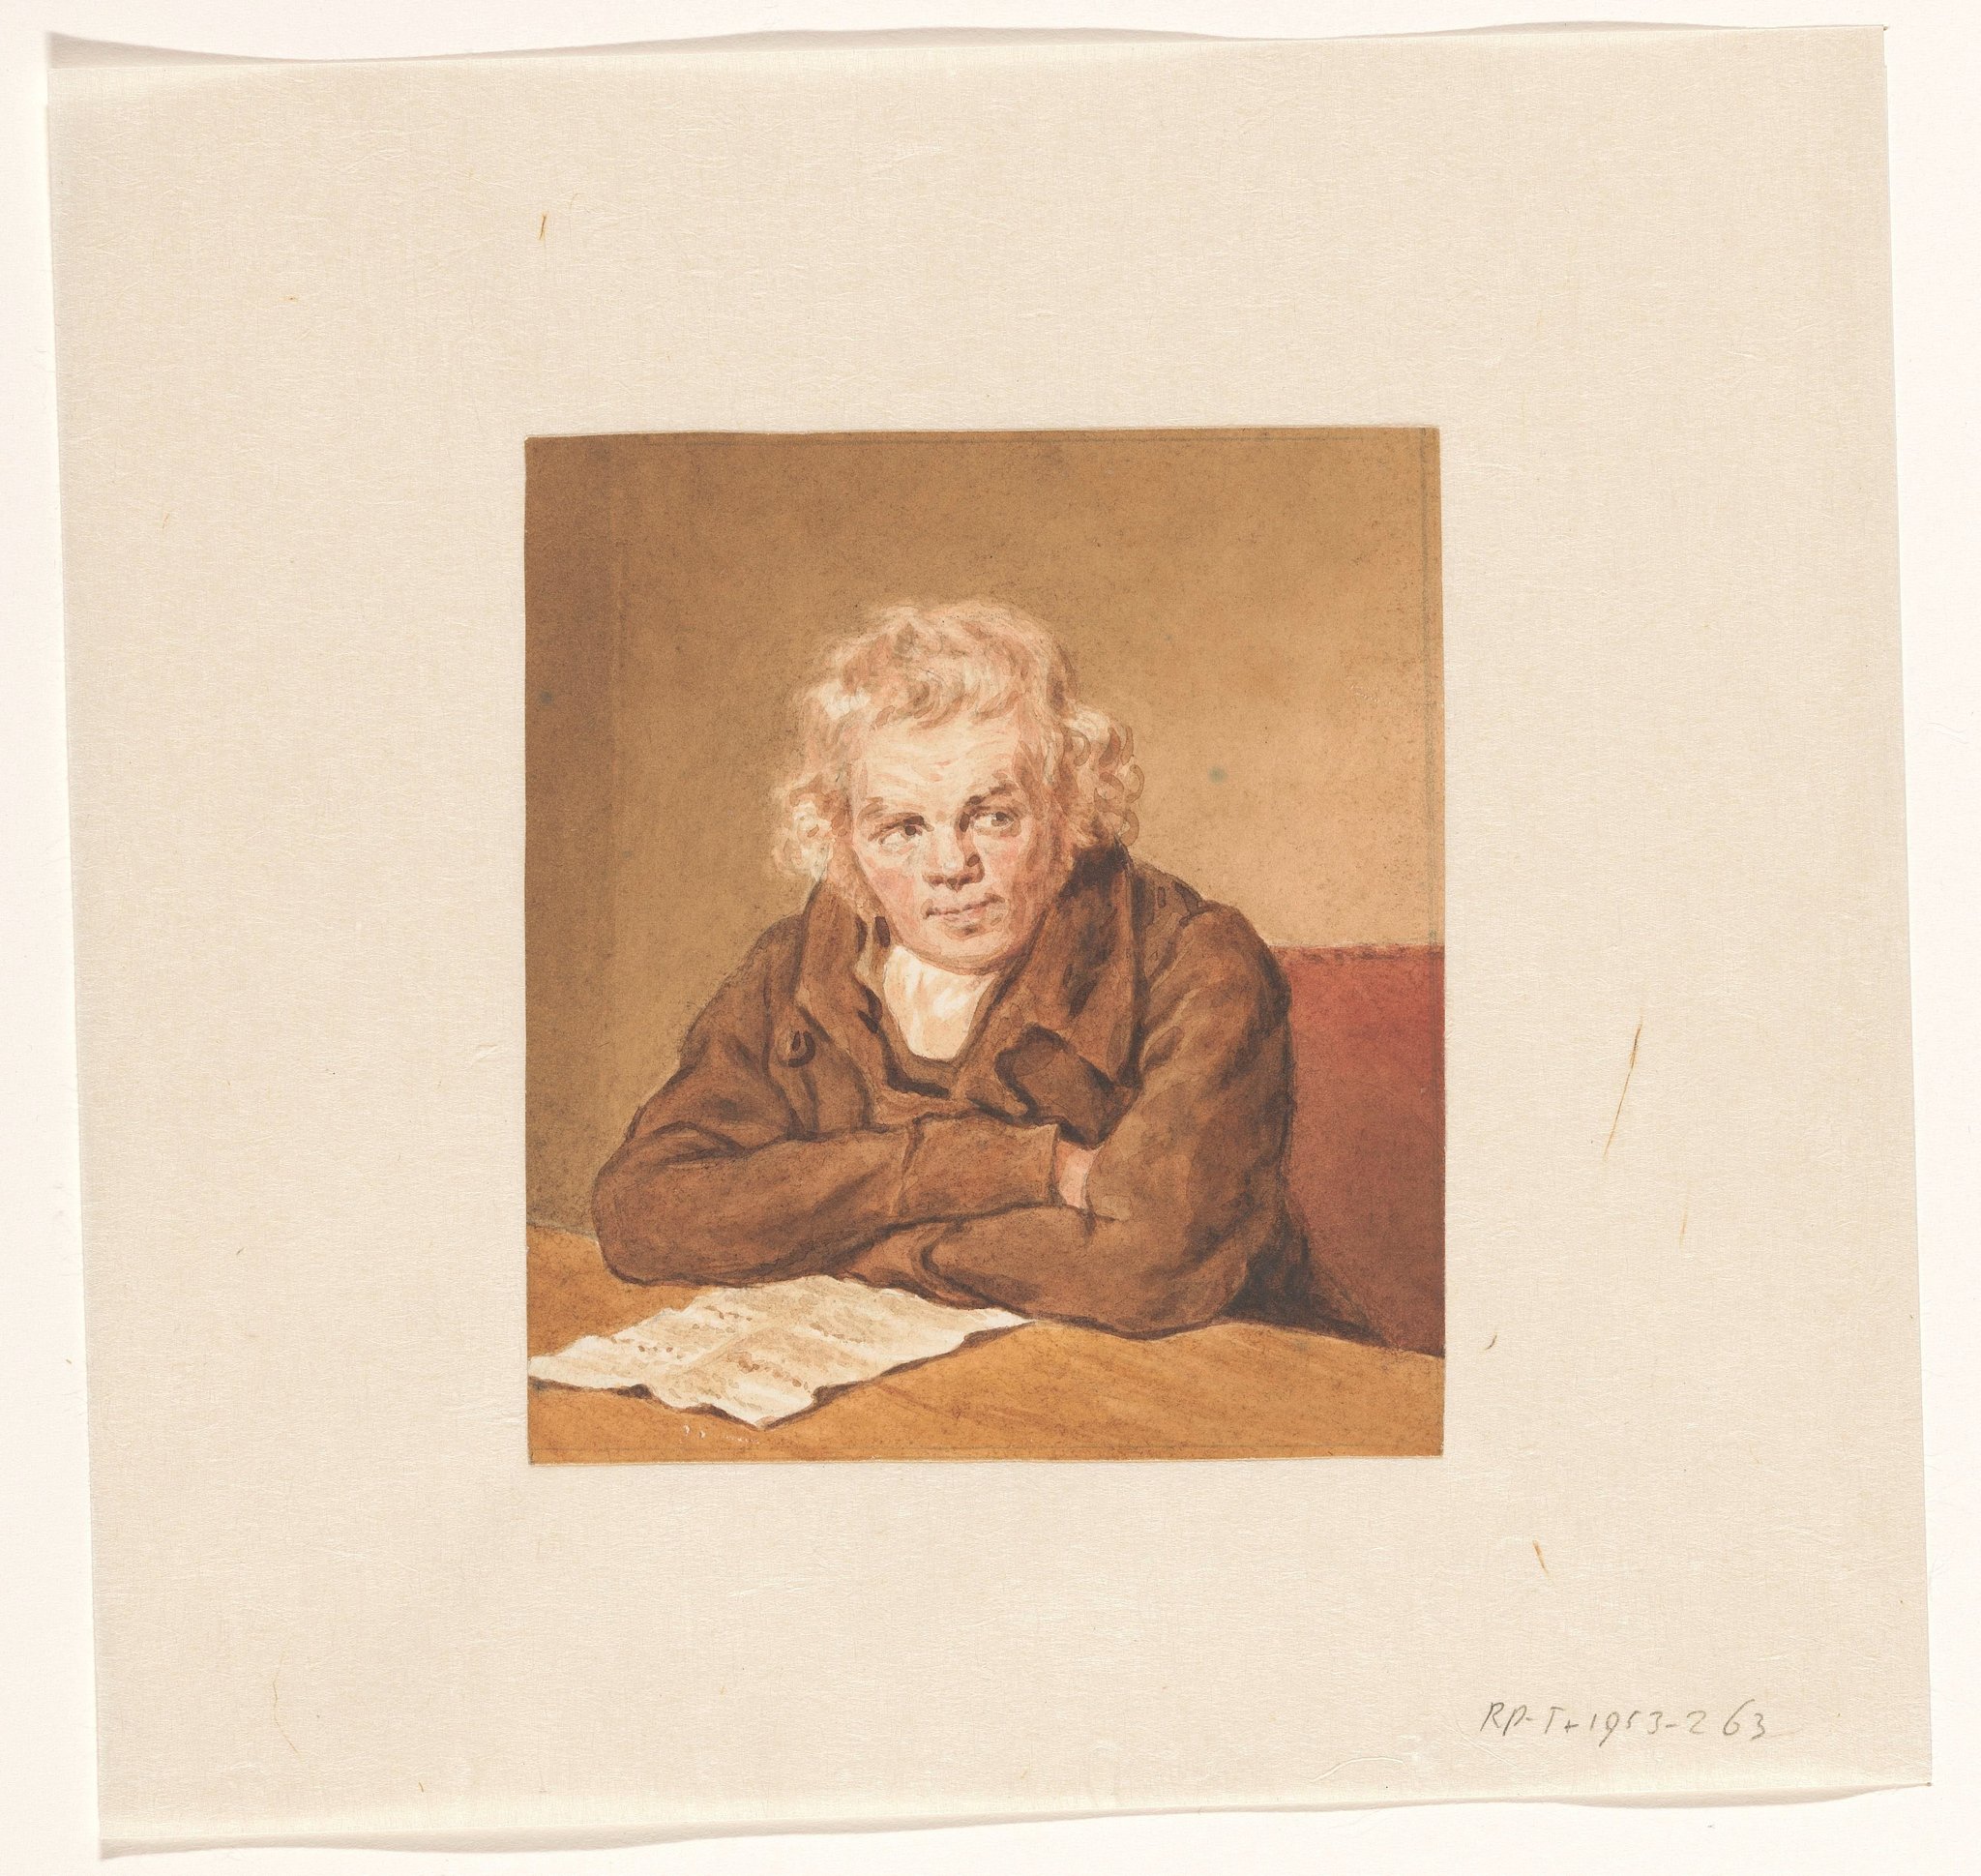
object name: drawing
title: Portret van Lourens van Schaick, zittend lezend aan tafel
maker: pieter christoffel wonder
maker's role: draughtsman, painter, print maker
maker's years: 1780-1852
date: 1790-1852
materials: paper, pencil, watercolor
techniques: brush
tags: reading, historical persons